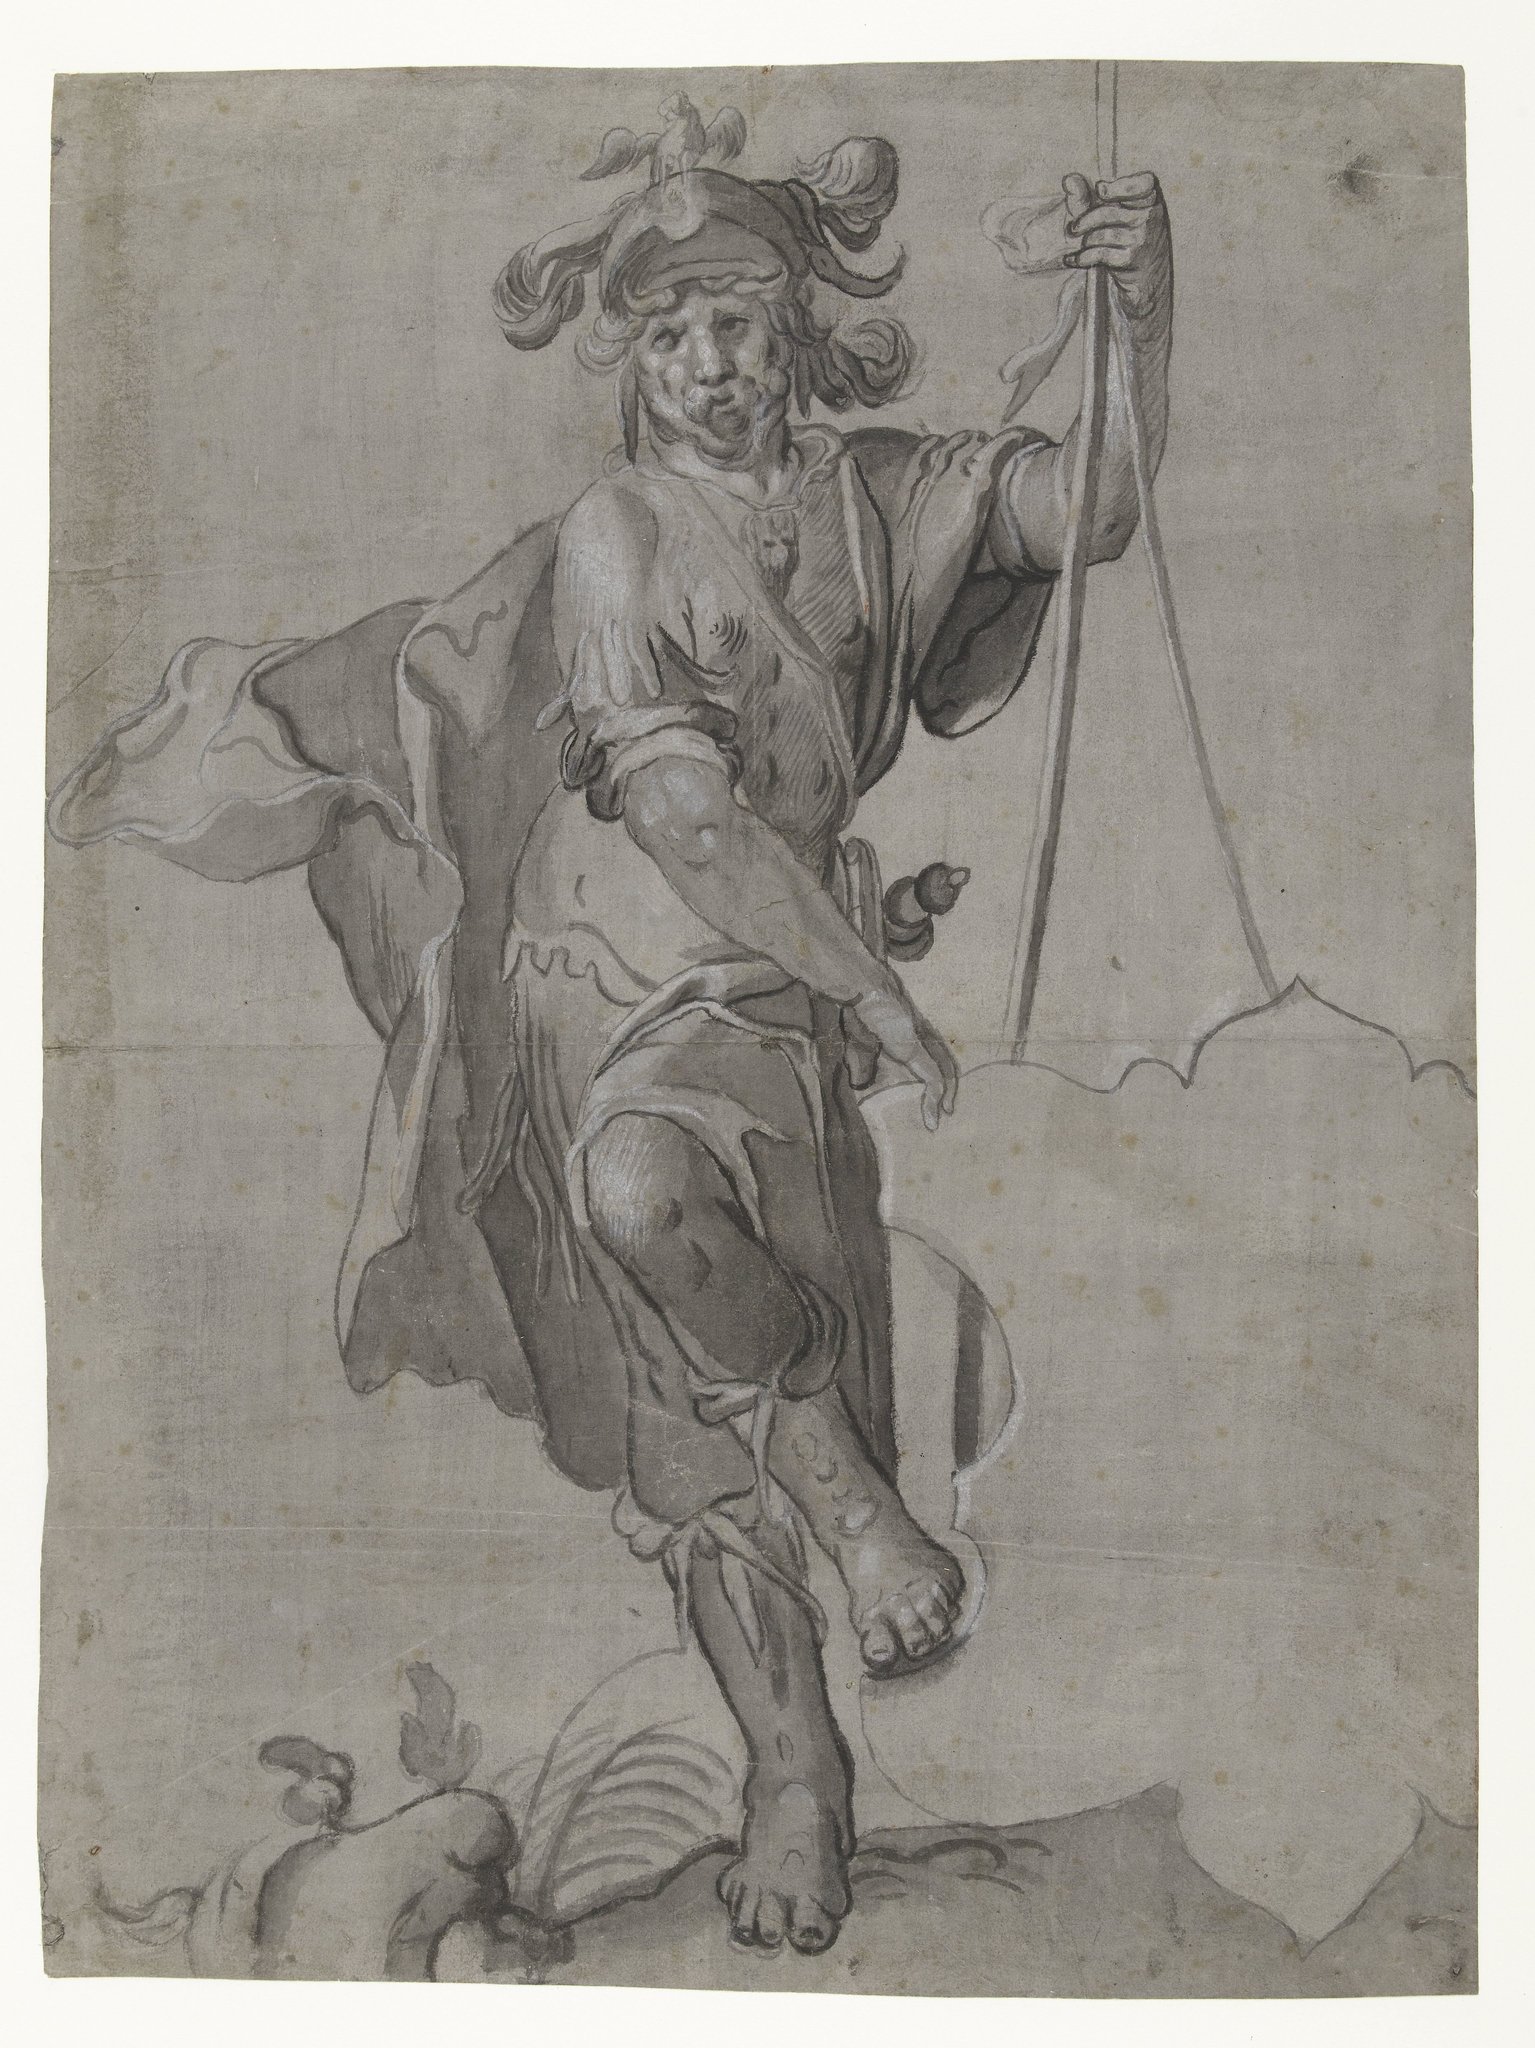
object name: design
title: Schildhouder in Romeins kostuum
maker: joachim wtewael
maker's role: draughtsman, painter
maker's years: 1566-1638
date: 1576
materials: paint, paper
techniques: brush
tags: helmet, protective weapons: shield, standing on one leg